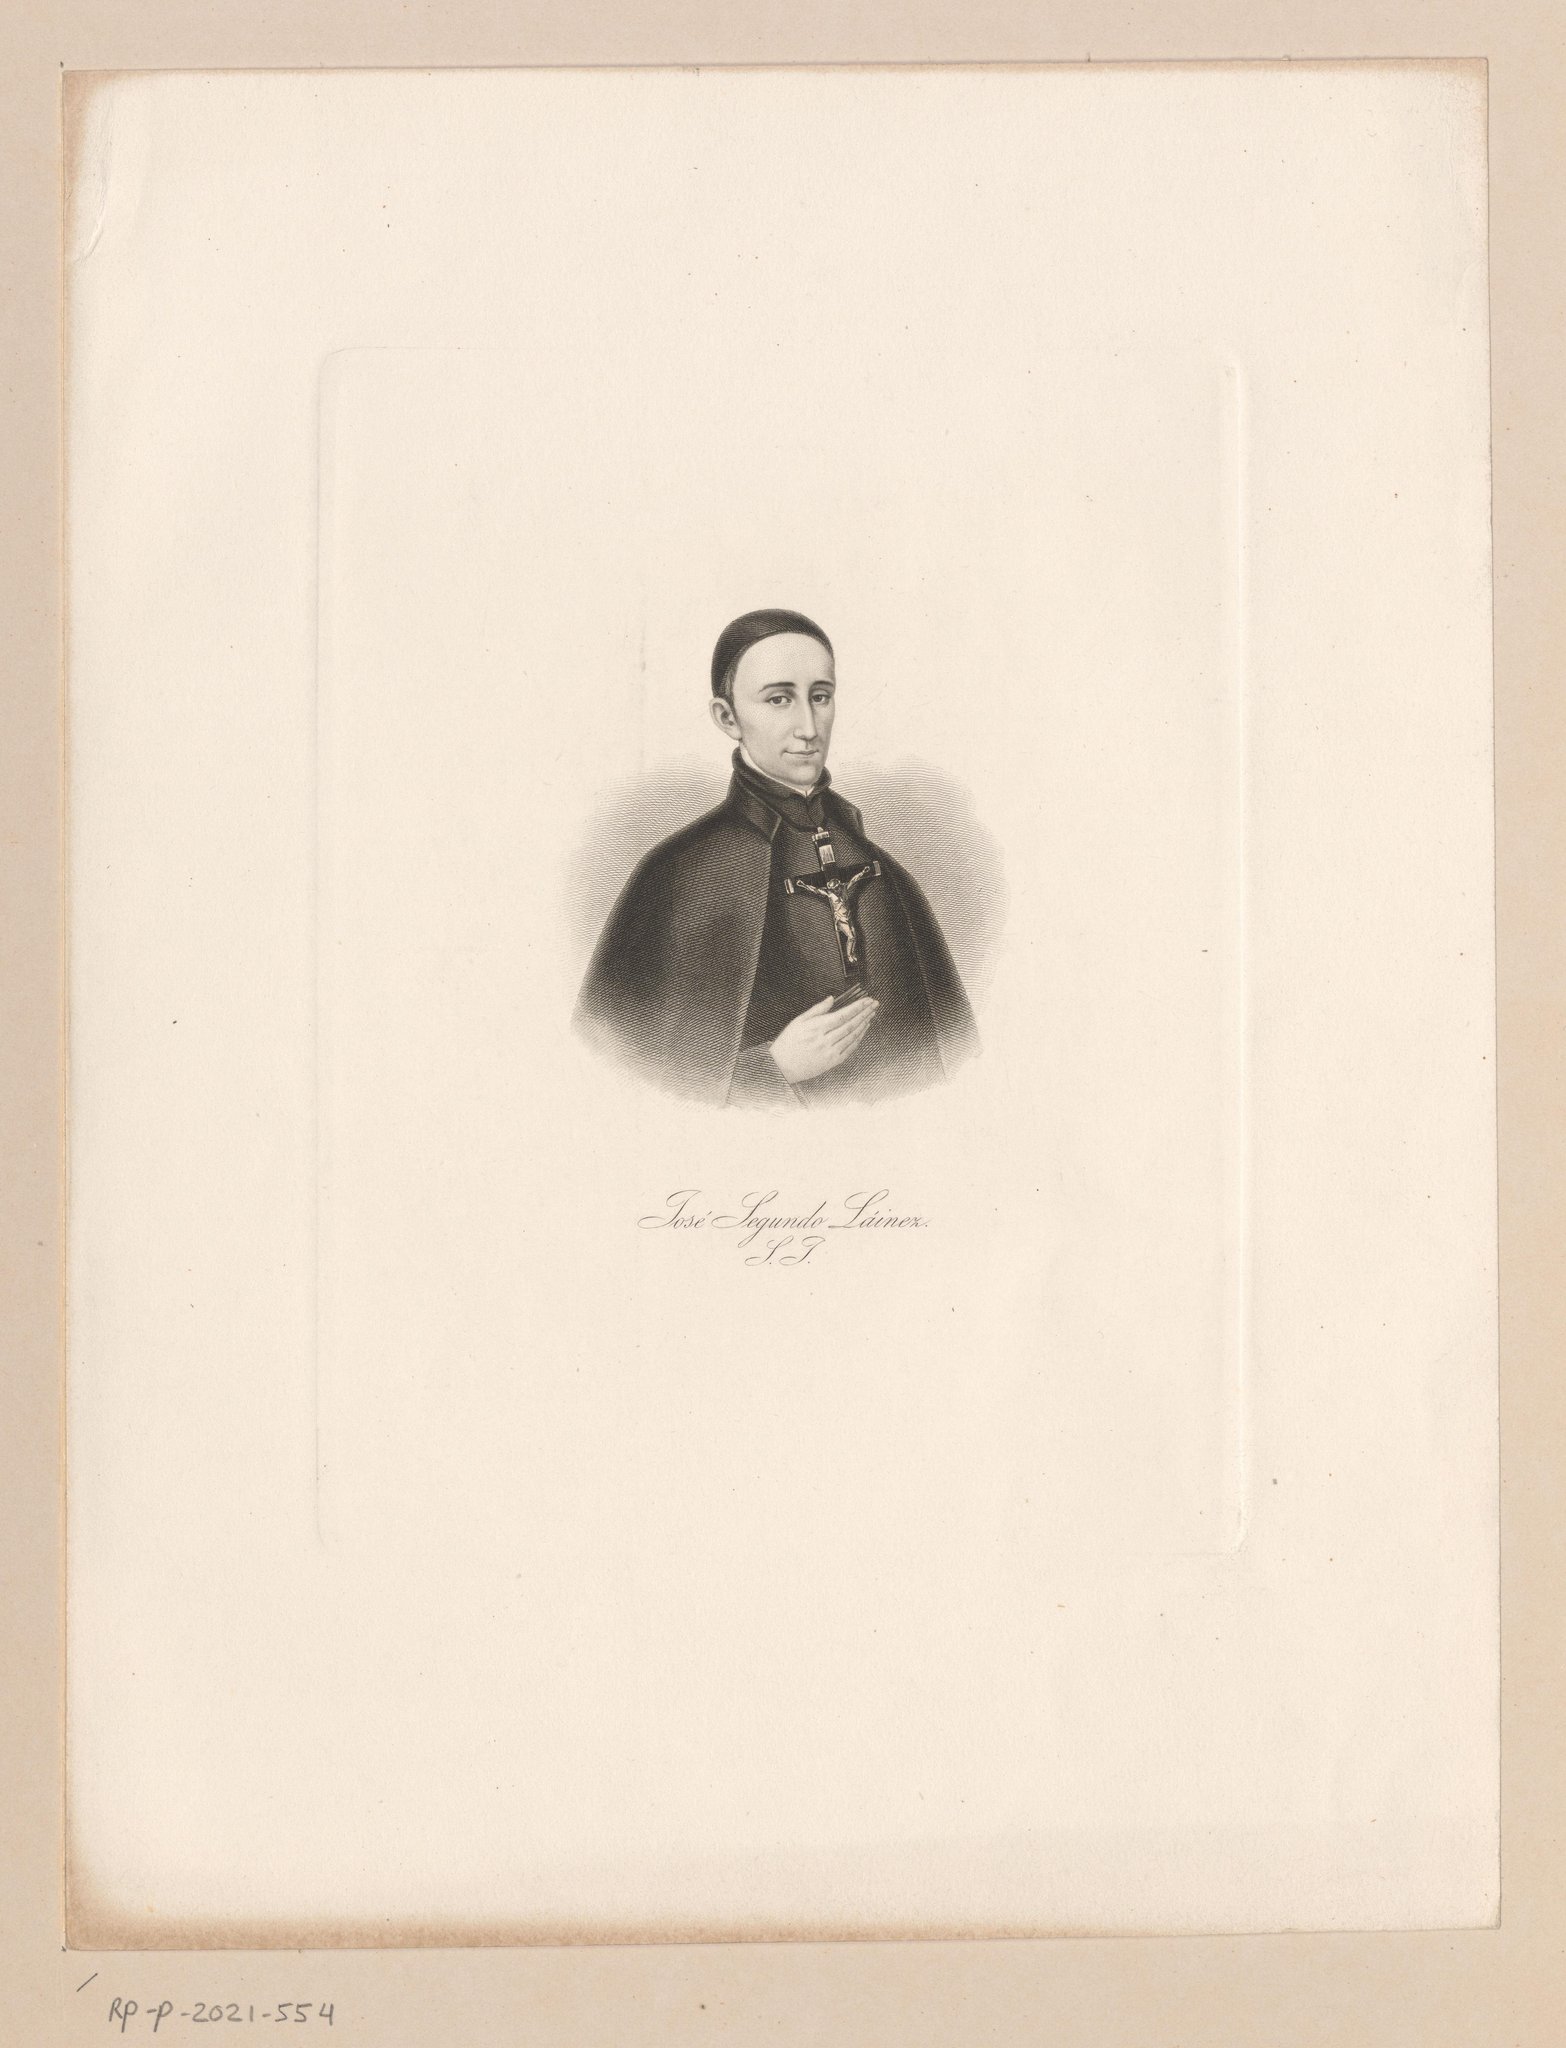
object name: print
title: Portret van José Segundo Láinez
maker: Anonymous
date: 1820-1899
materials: paper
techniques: etching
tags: archbishop, bishop, etc. (roman catholic), historical persons